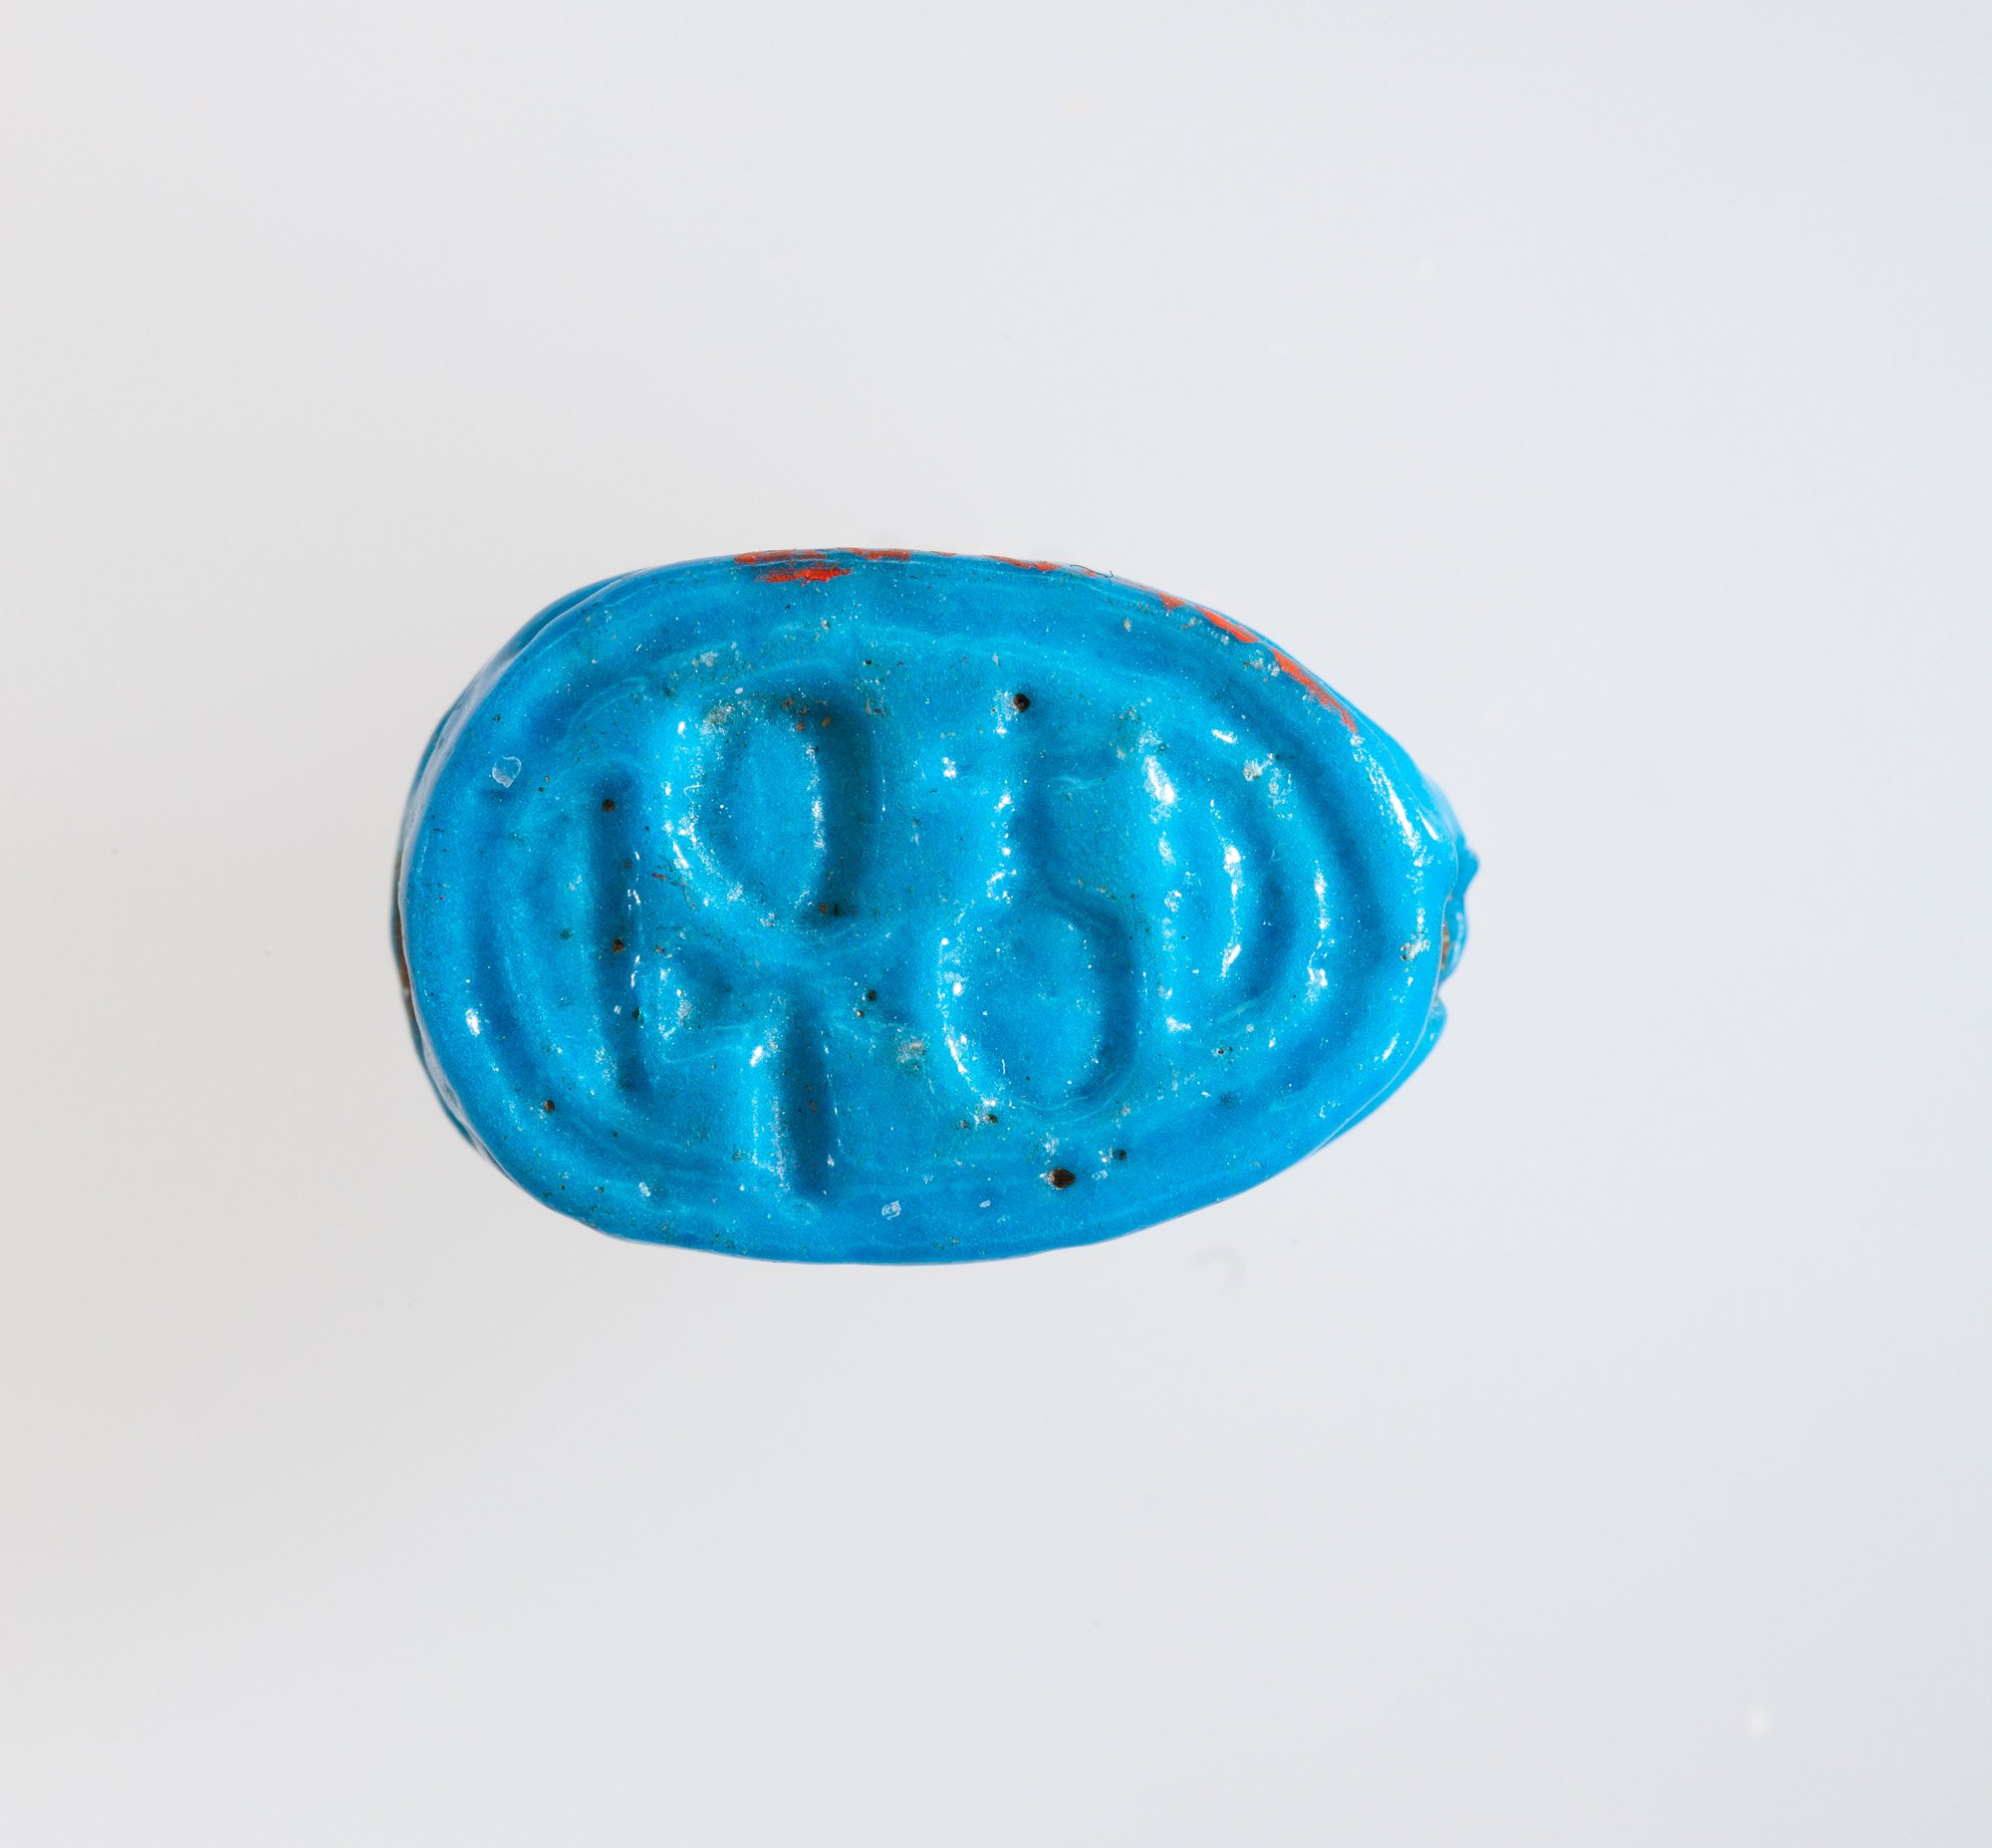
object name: scarab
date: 1479-1458 BCE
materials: faience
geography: egypt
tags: scarabs